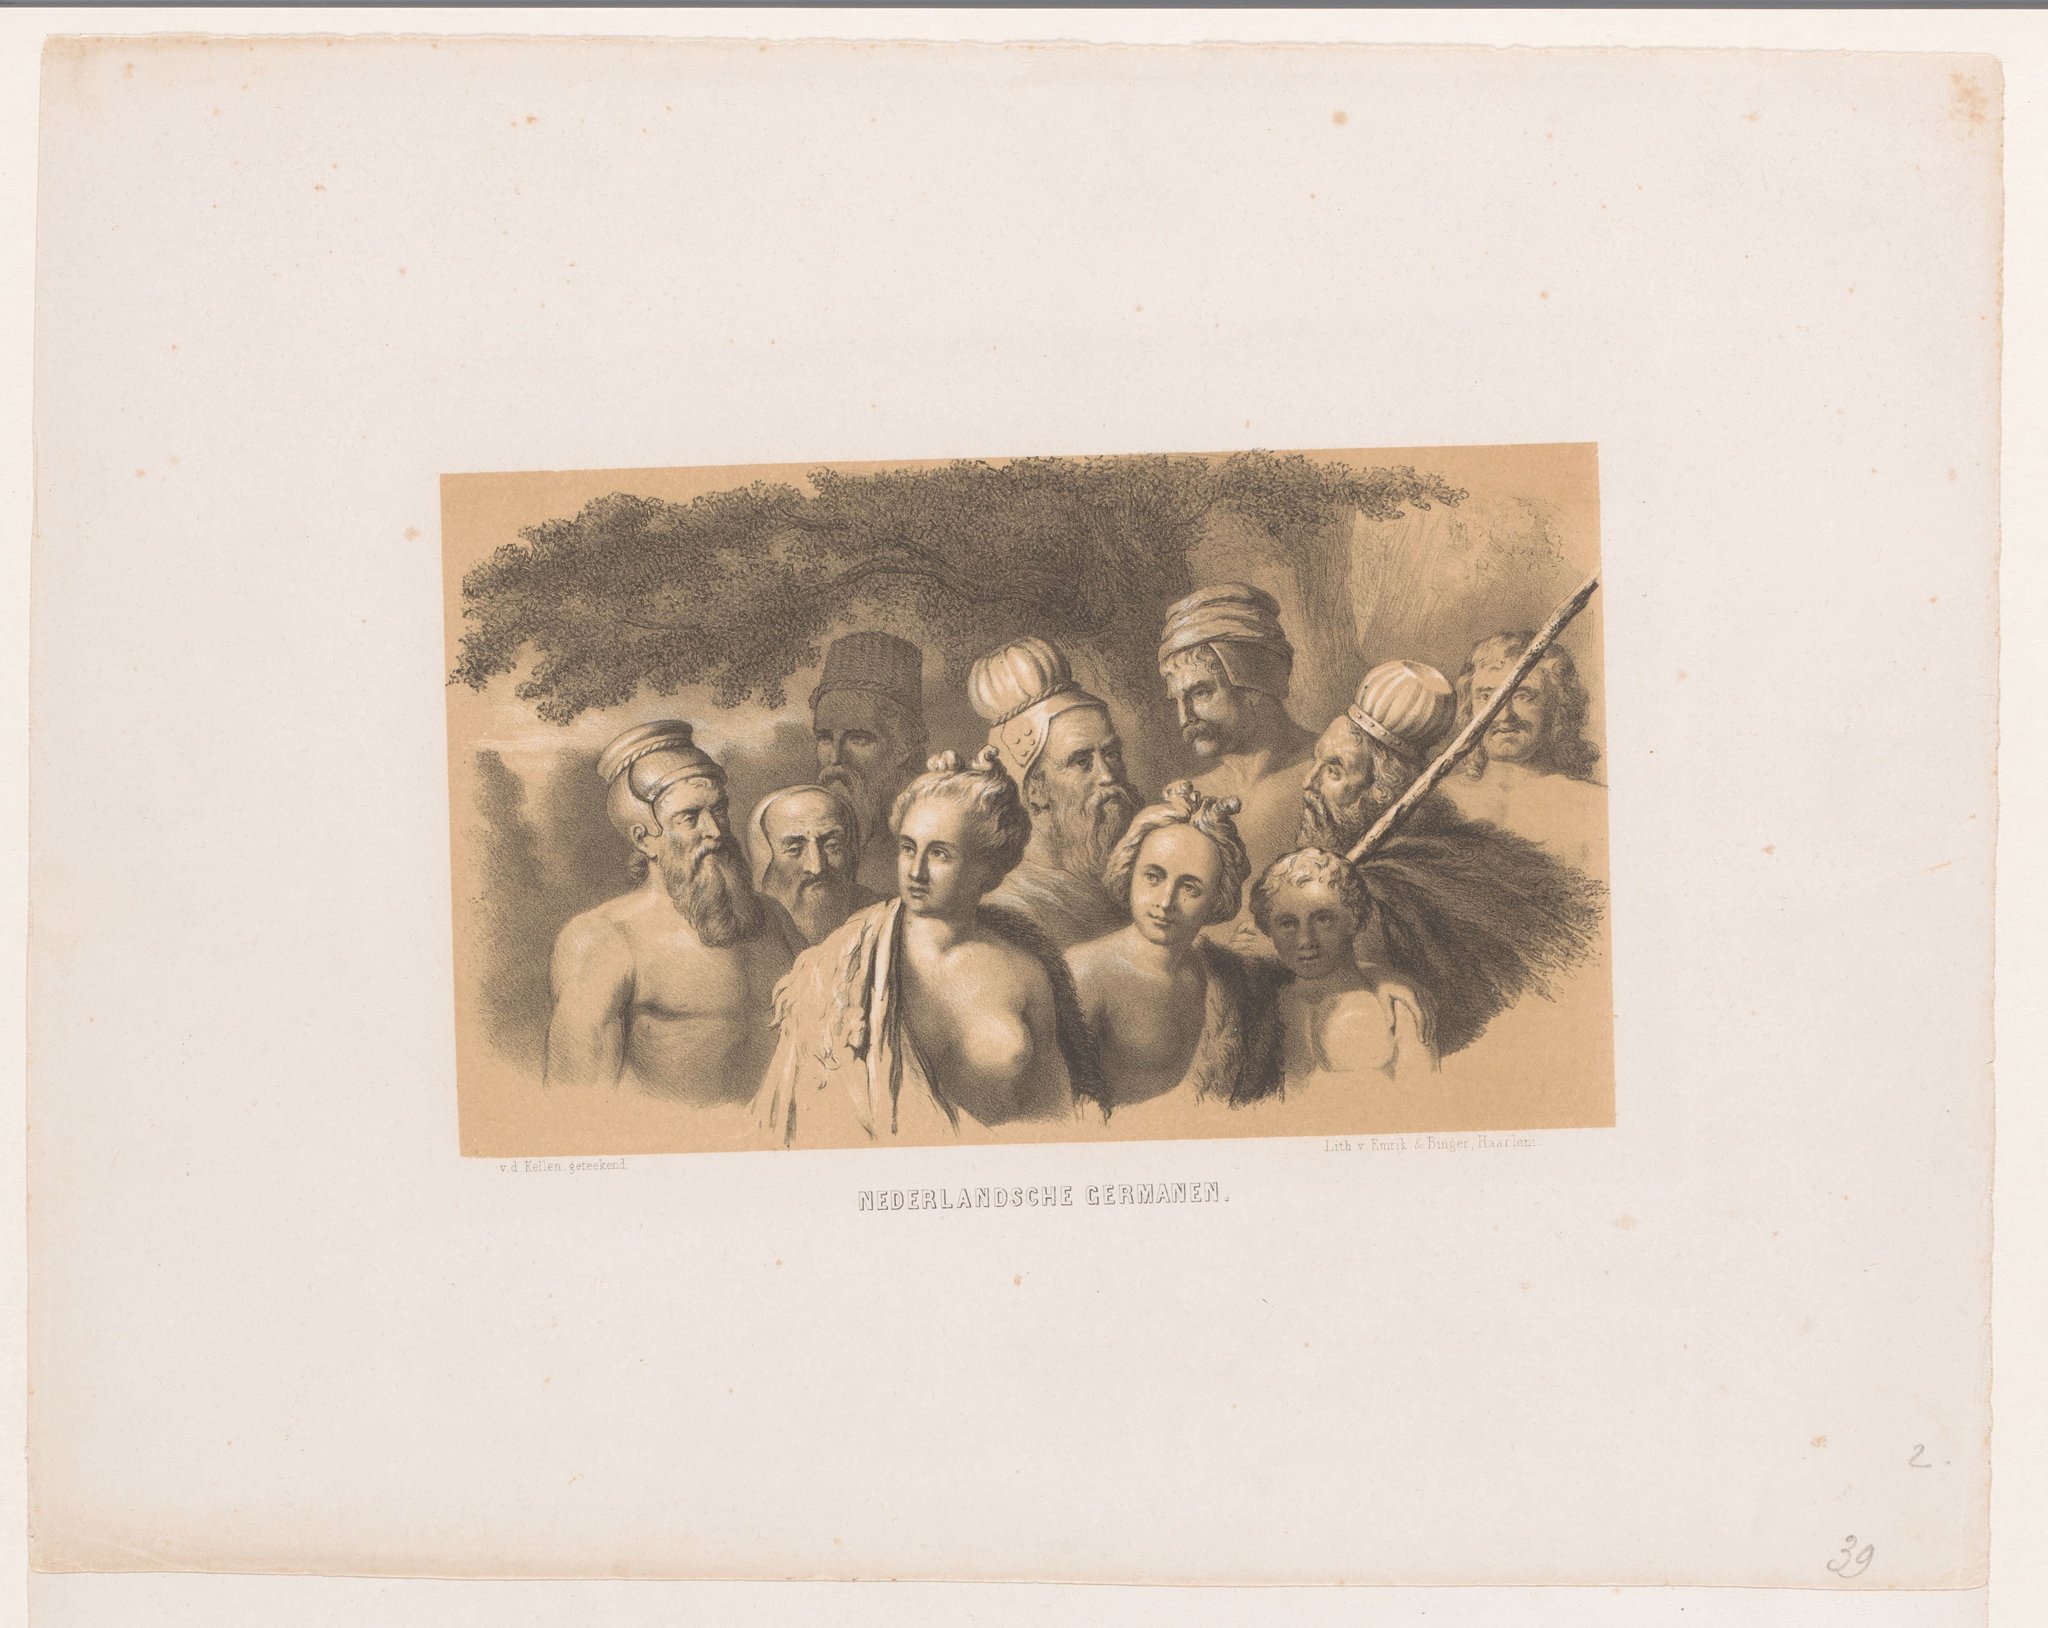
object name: print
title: Nederlandse Germanen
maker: david van der kellen (1827-1895)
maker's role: draughtsman, print maker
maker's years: 1827-1895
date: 1857-1864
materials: paper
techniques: tone lithography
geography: haarlem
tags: extinct, 'historical' peoples (with name), netherlands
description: Illustratie voor: W.J. Hofdijk, Ons voorgeslacht in zijn dagelyksch leven geschilderd, Kruseman, Haarlem 1859-1864.